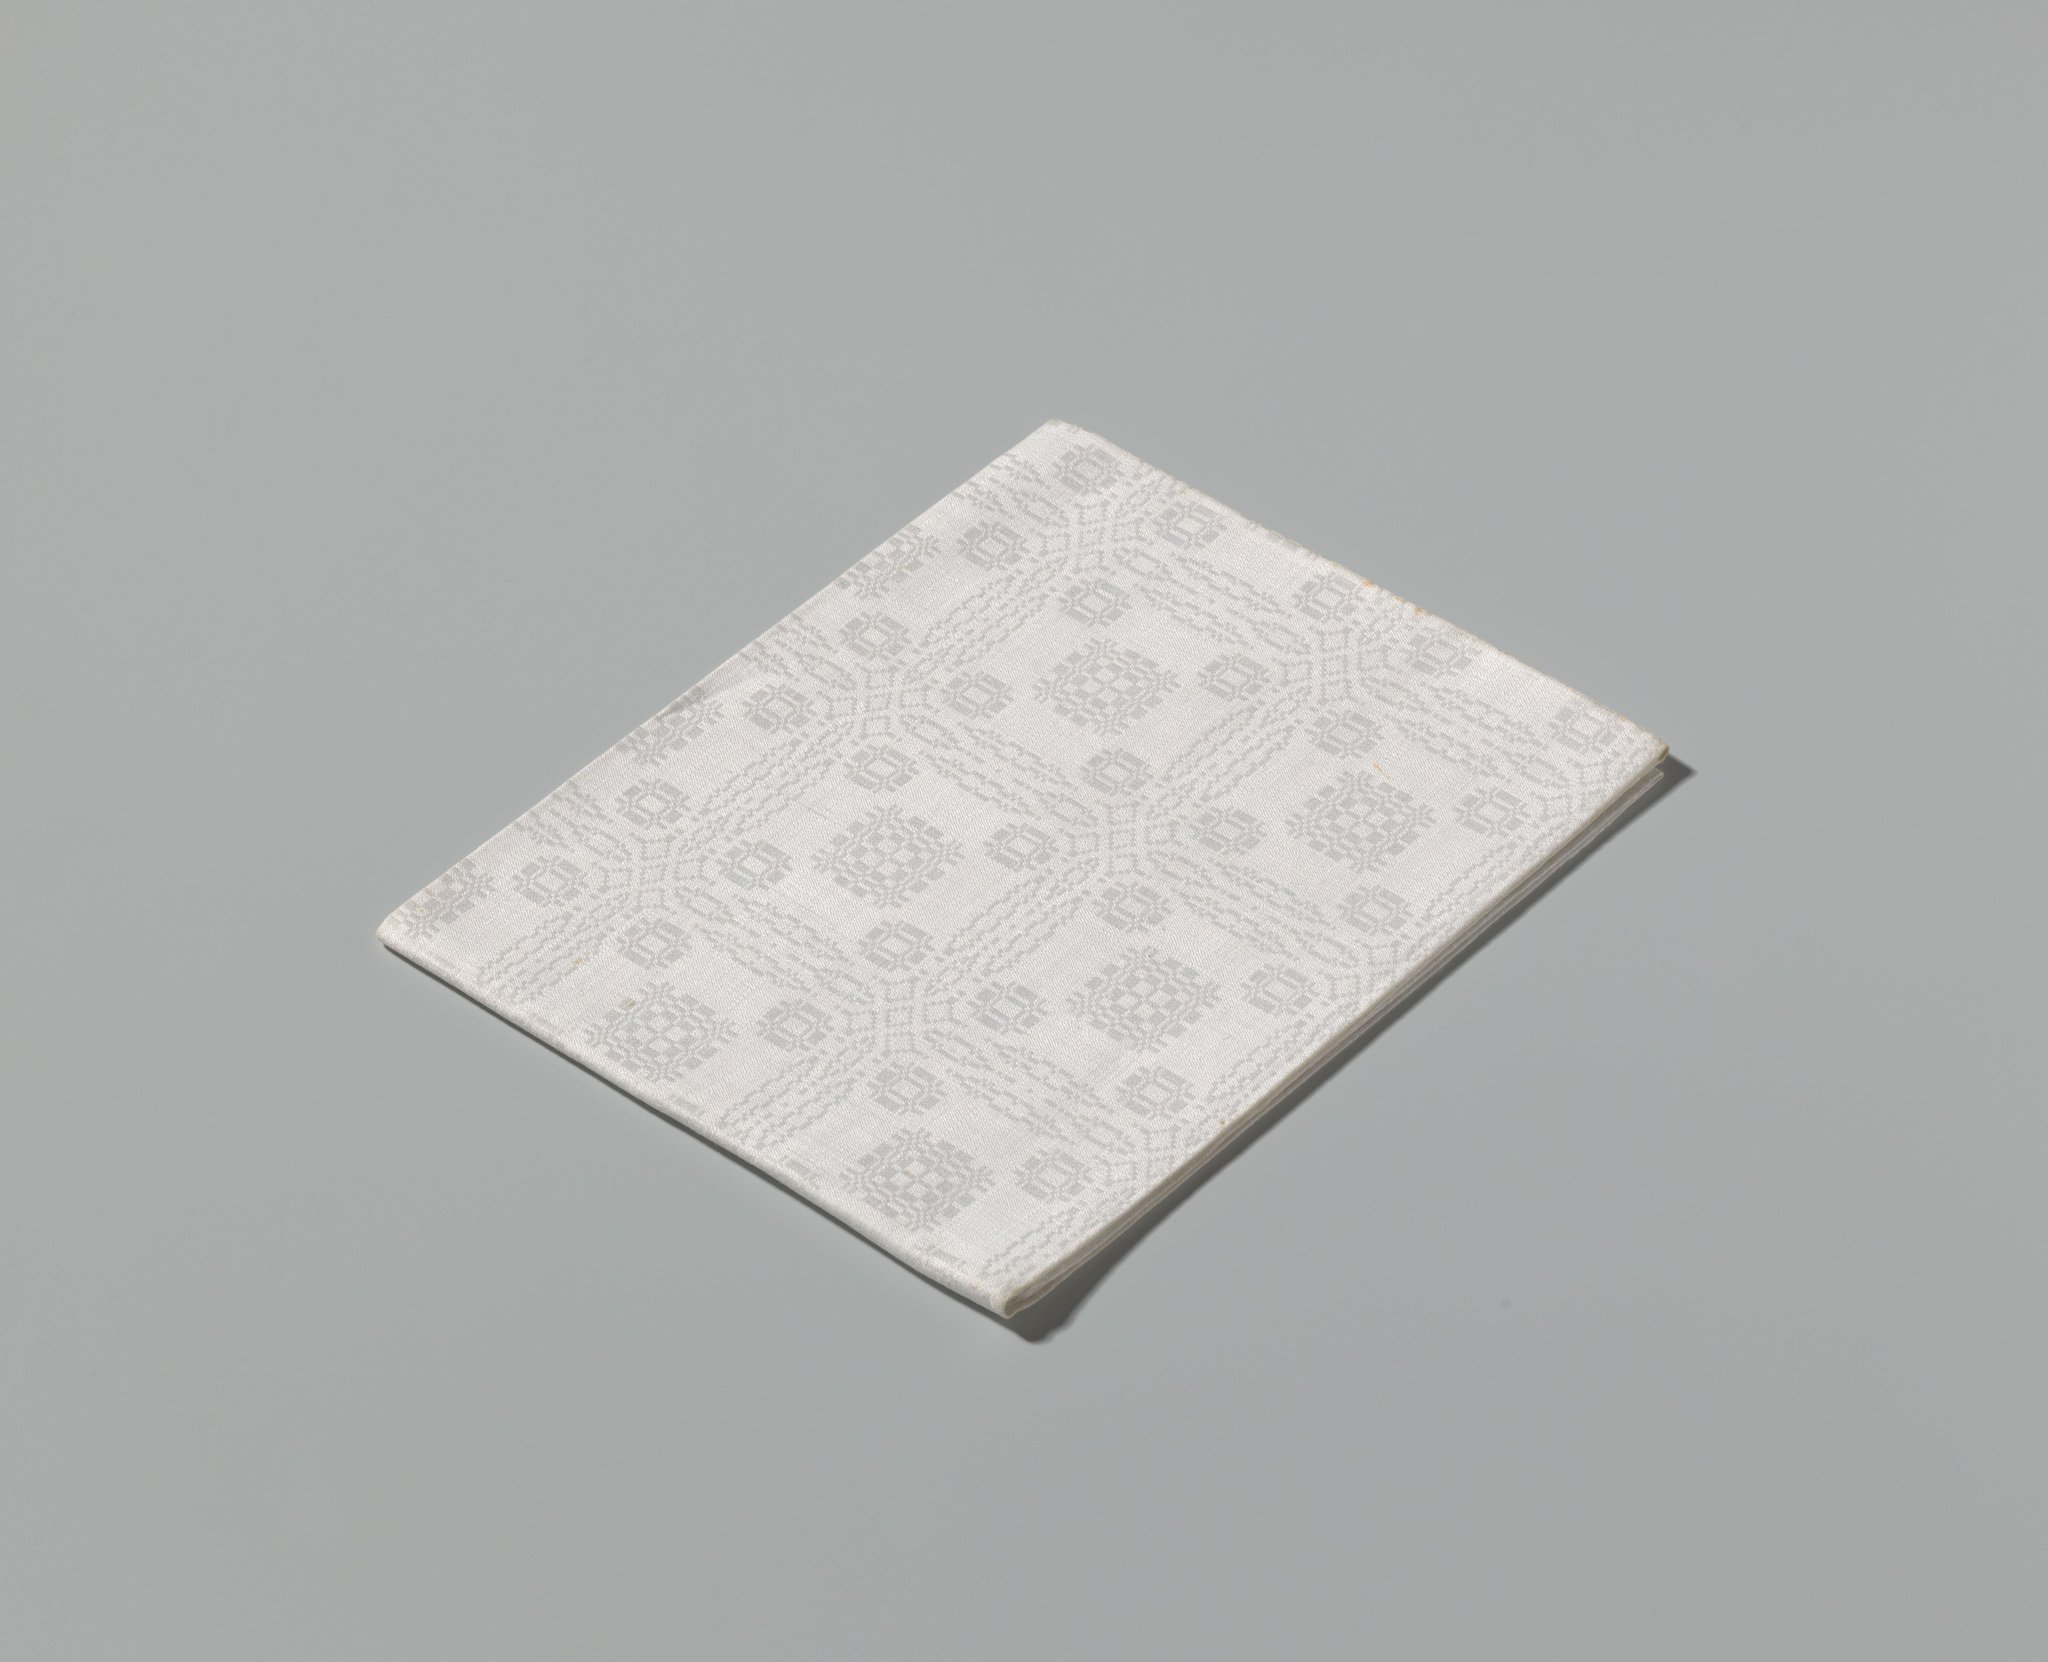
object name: napkin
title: Servet van linnen met pellenpatroon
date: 1690-1734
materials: linen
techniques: peeled fabric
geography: northern netherlands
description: wit linnen servet met pellen patroon, merk TC 27 en monogram TC 27